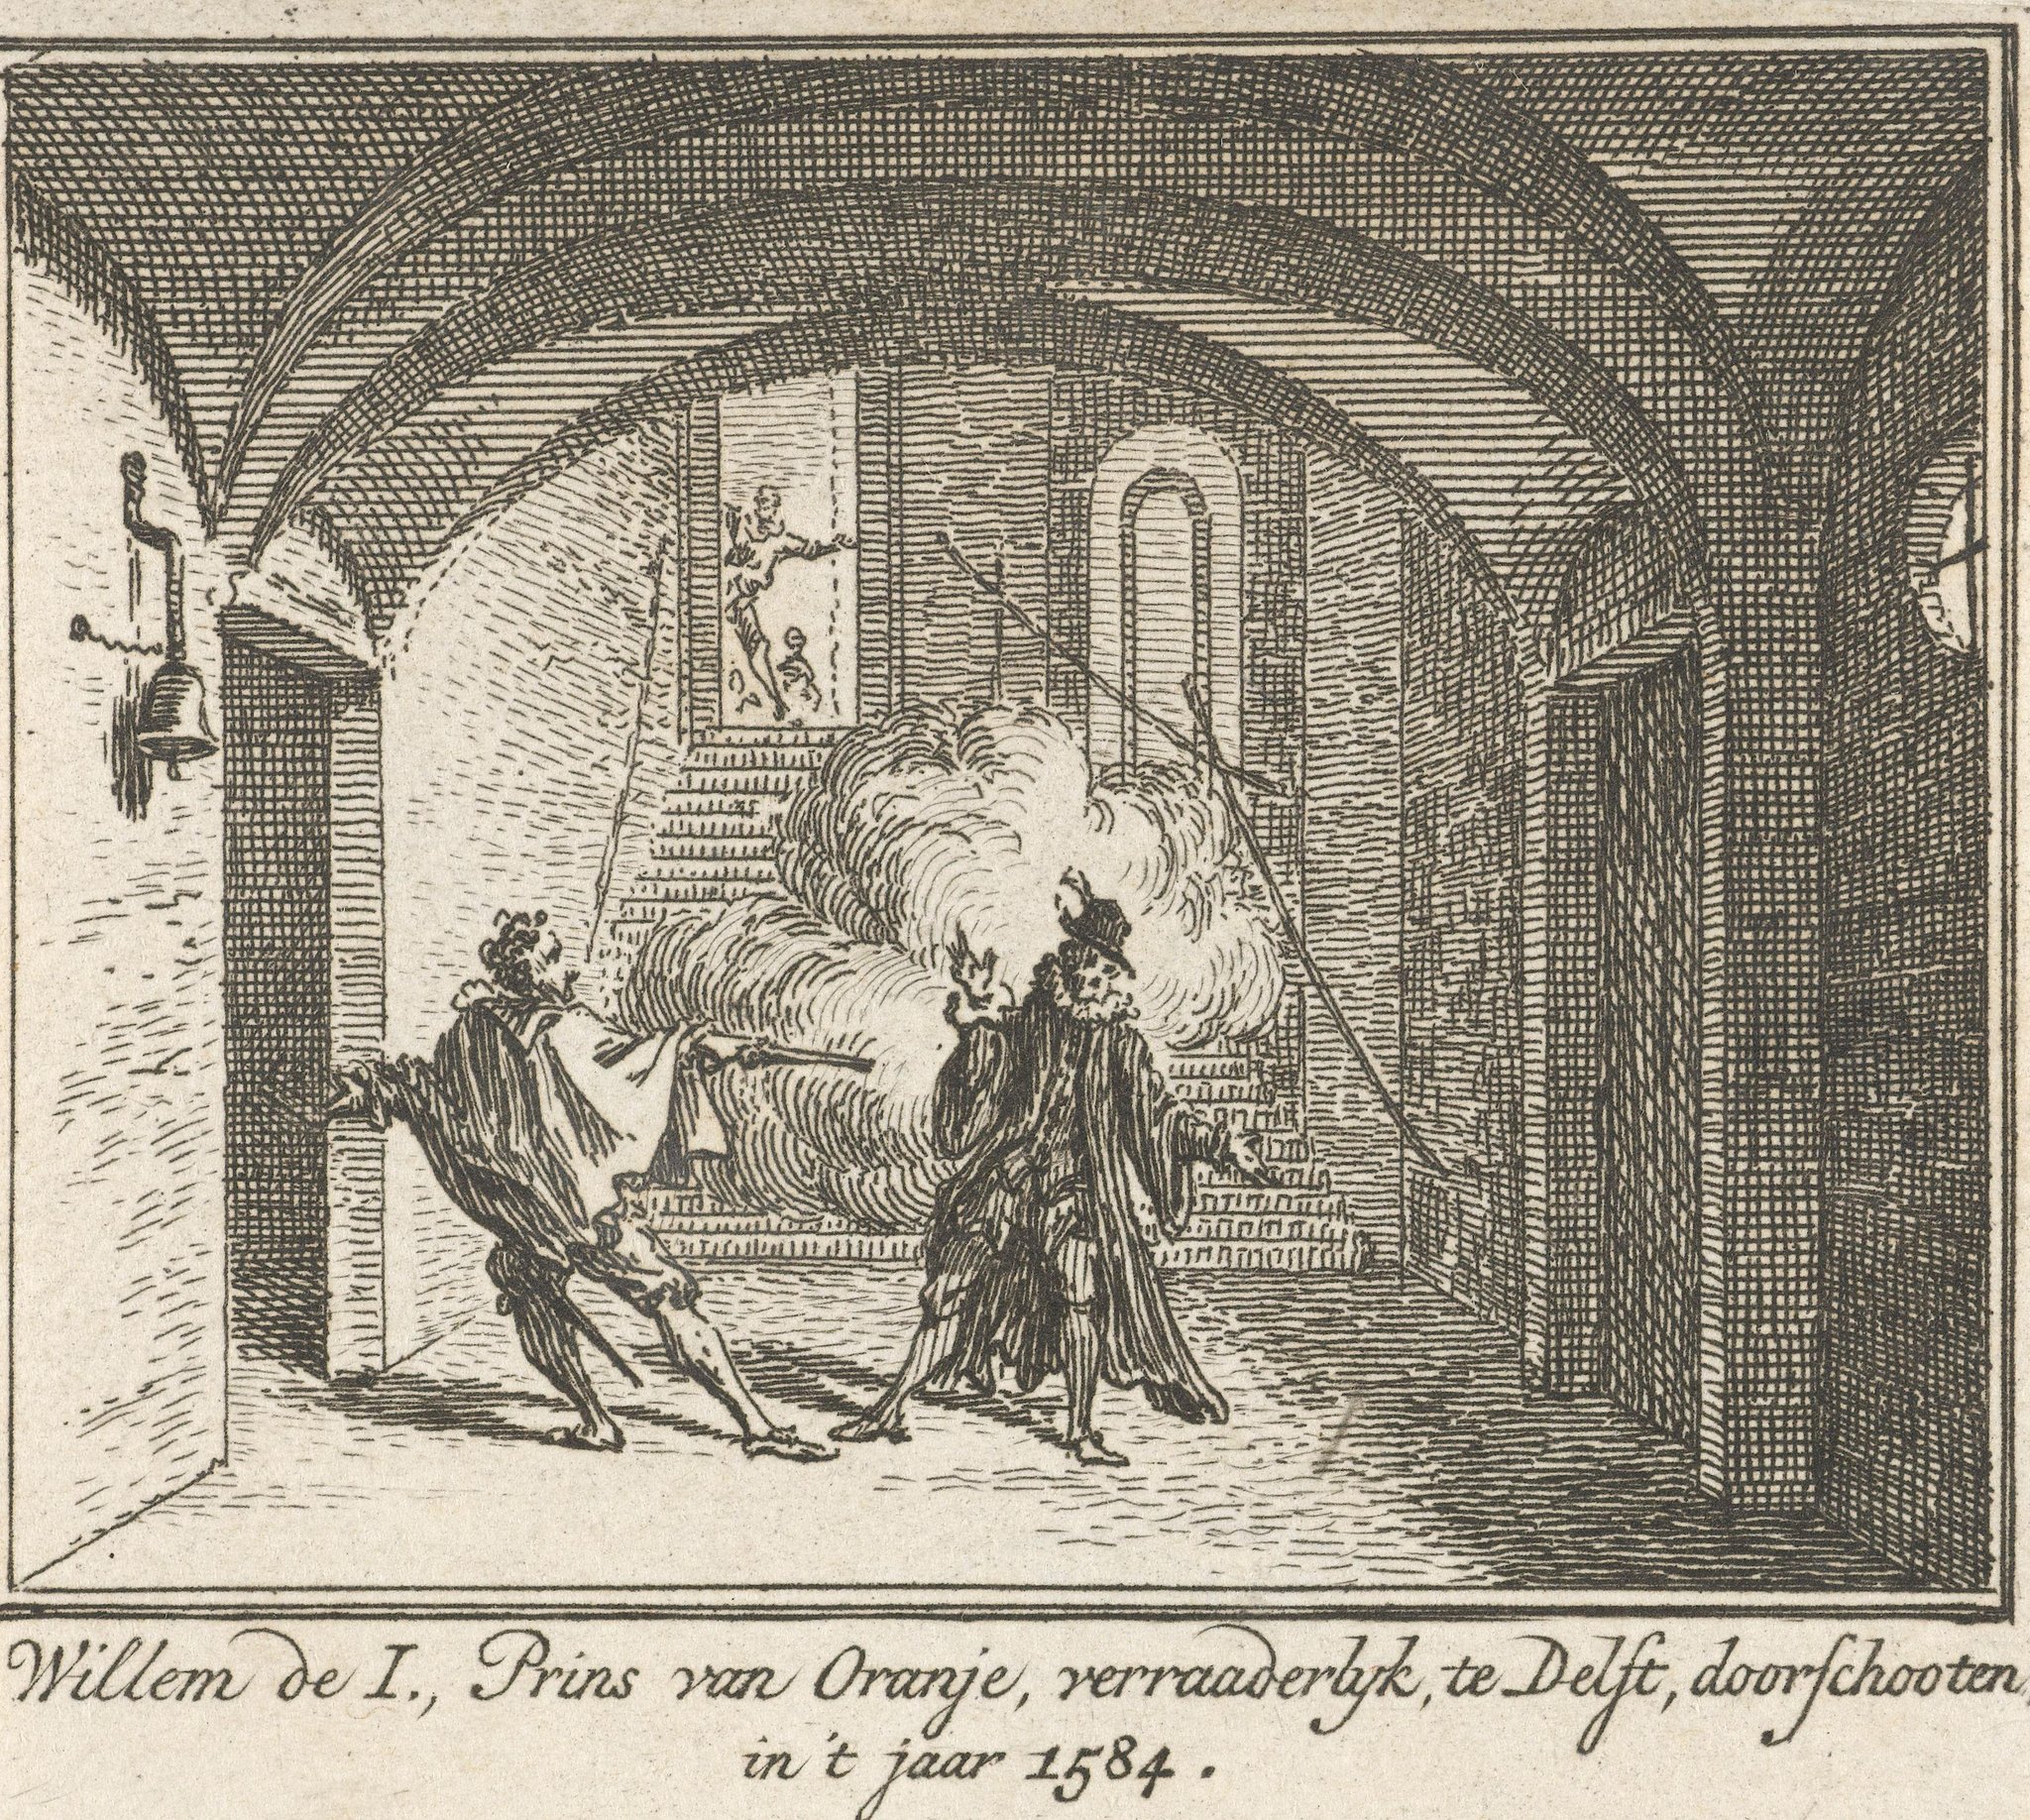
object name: history print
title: De moord op Willem van Oranje, 1584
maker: simon fokke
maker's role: draughtsman, print maker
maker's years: 1712-1784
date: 1756-1758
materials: paper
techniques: etching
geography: northern netherlands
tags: delft, william i (prince of orange), attempt, political murder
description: Gebruikt als illustratie in: Jan Wagenaar en Simon Fokke, Vaderlandsche historie verkort, en by vraagen en antwoorden voorgesteld, Isaak Tirion, Amsterdam 1758, p. 72. Dit nummer is een door het RPK toegevoegd nummer en staat niet in Frederik Muller, het werk waar de prent voor is gemaakt of uit afkomstig is, staat wel vermeld in Frederik Muller. Verkleinde herhaling van de prent FMH 886A.